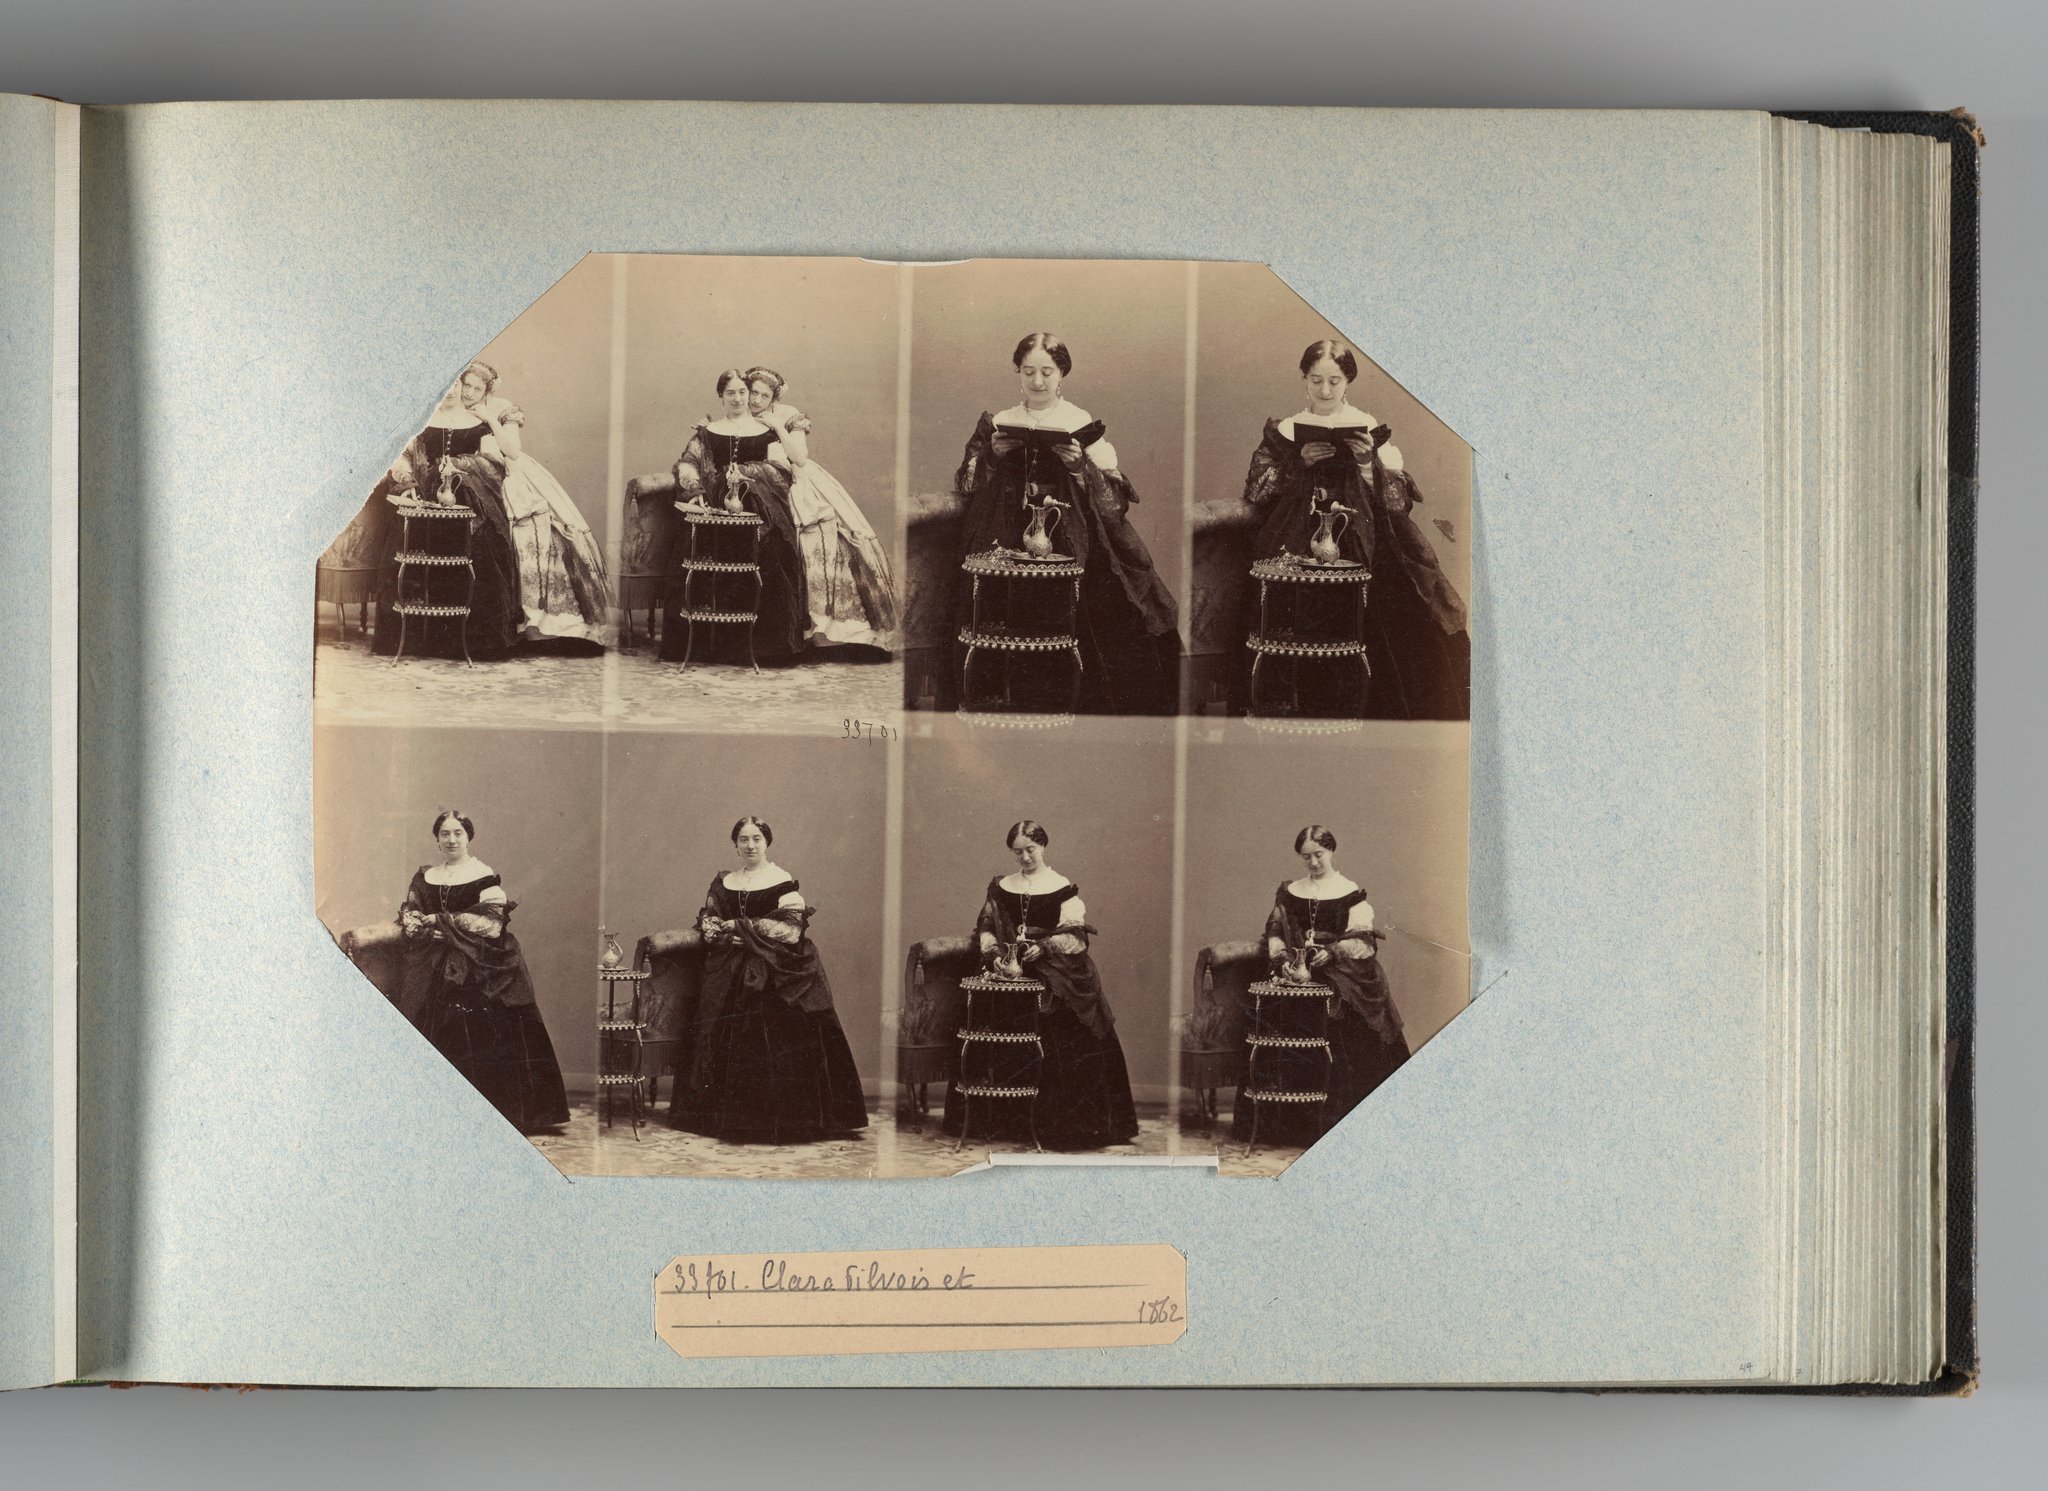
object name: photograph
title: Clara Pilvois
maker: andré-adolphe-eugène disdéri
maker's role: artist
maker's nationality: french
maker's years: 1819-1889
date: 1862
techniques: albumen silver print, glass negative